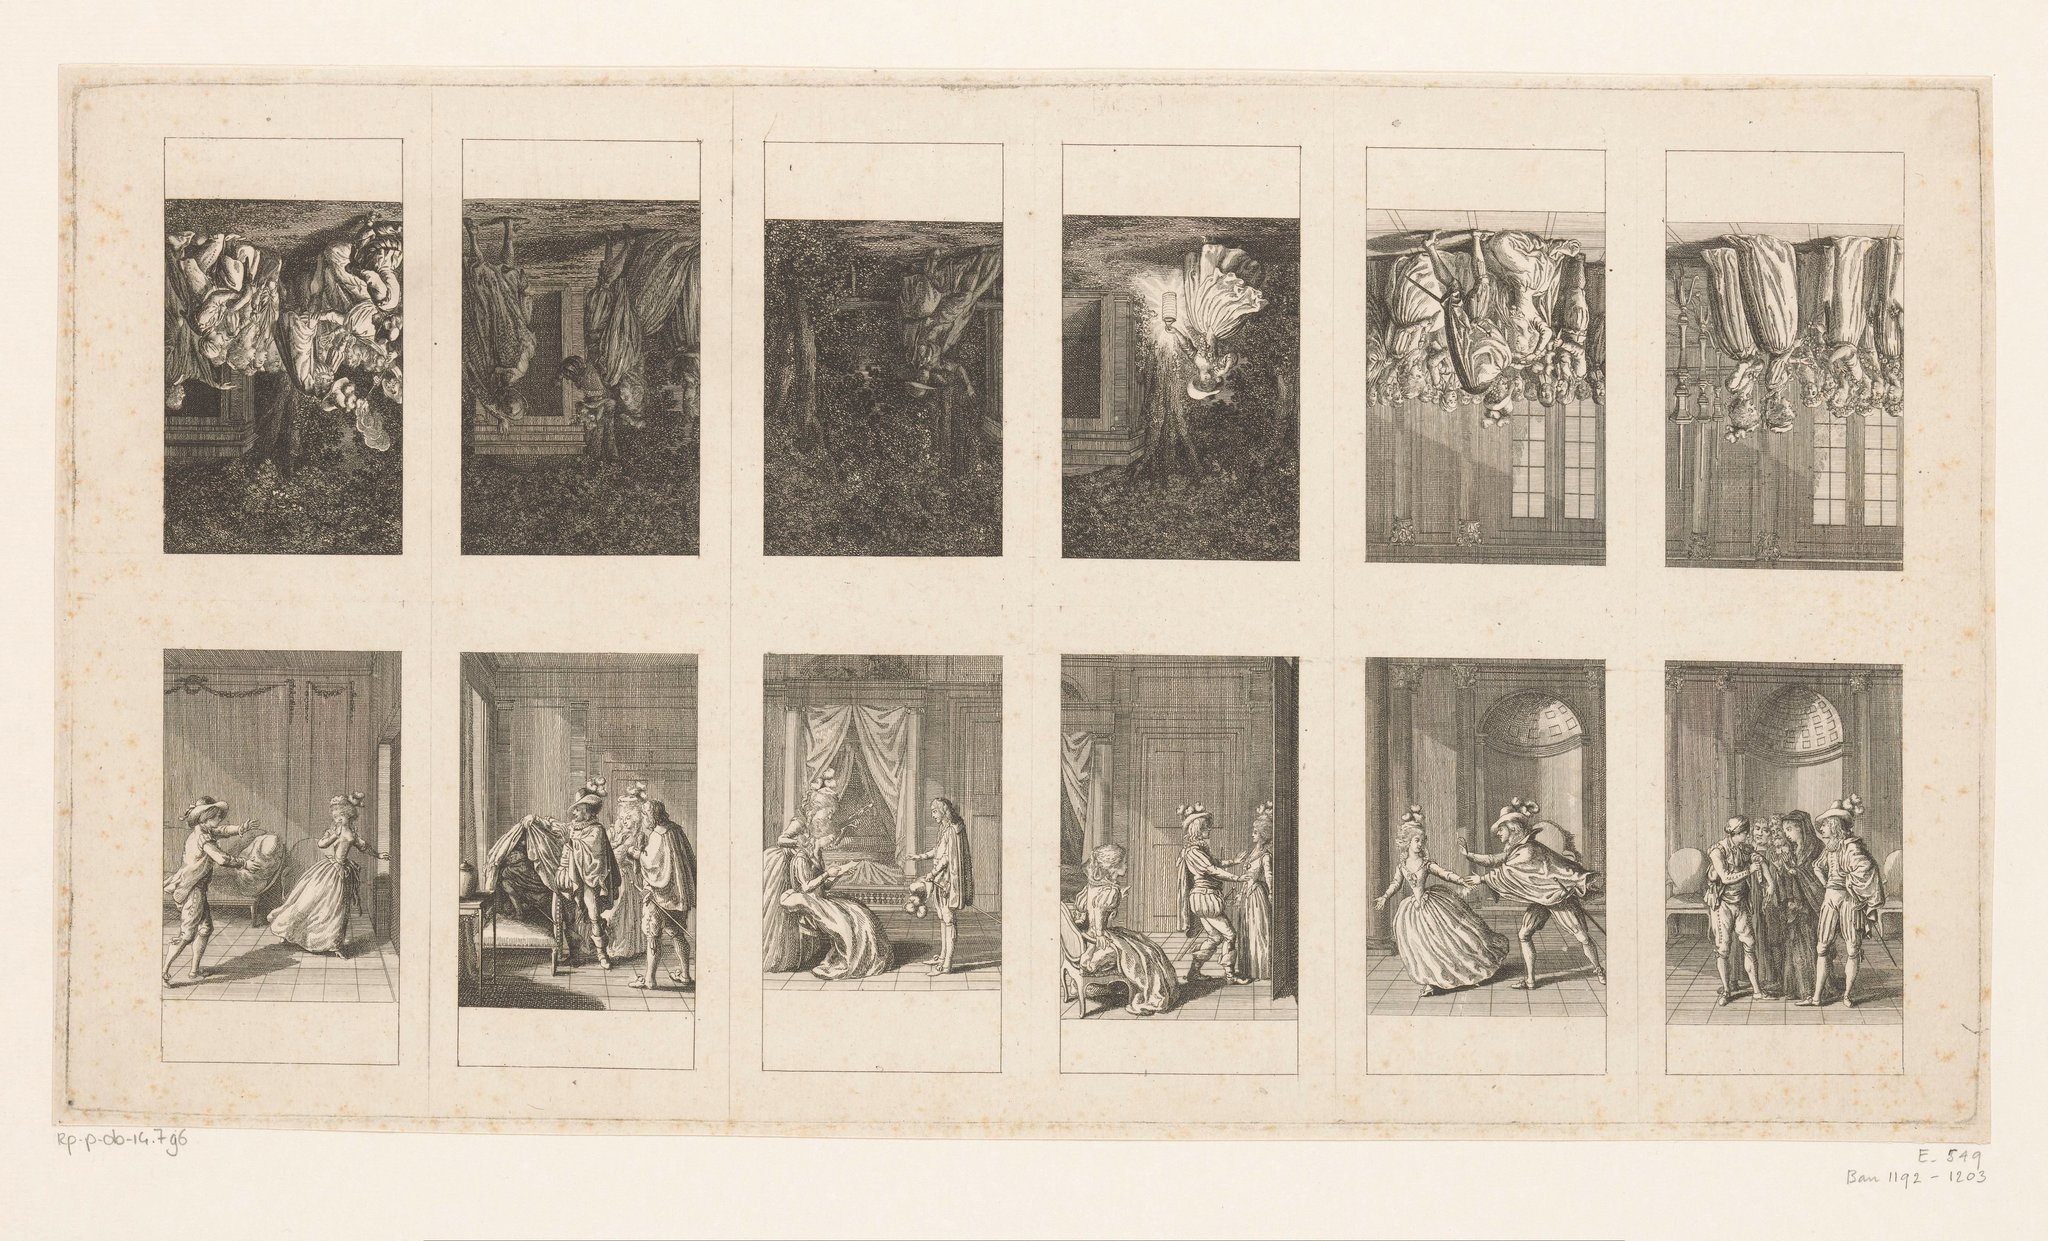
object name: print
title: Twaalf voorstellingen uit le Mariage de Figaro van Beaumarchais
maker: daniel nikolaus chodowiecki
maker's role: draughtsman, print maker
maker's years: 1726-1801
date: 1786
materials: paper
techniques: etching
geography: berlin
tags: paris, publisher, adolescent, young woman, maiden, reading, literature, garden, pursuit of a woman, prowling, lantern, lovers' meeting, hiding, hiding oneself, night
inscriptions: collector's mark: Lugt 2228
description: Vervaardigd voor 'le Mariage de Figaro' van Pierre Augustin Caron de Beaumarchais. Latere staat gebruikt voor: Almanac de Gotha contenant diverses connoissances curieuses et utiles pour l'année (...). Gotha: C. W. Ettinger, 1785.